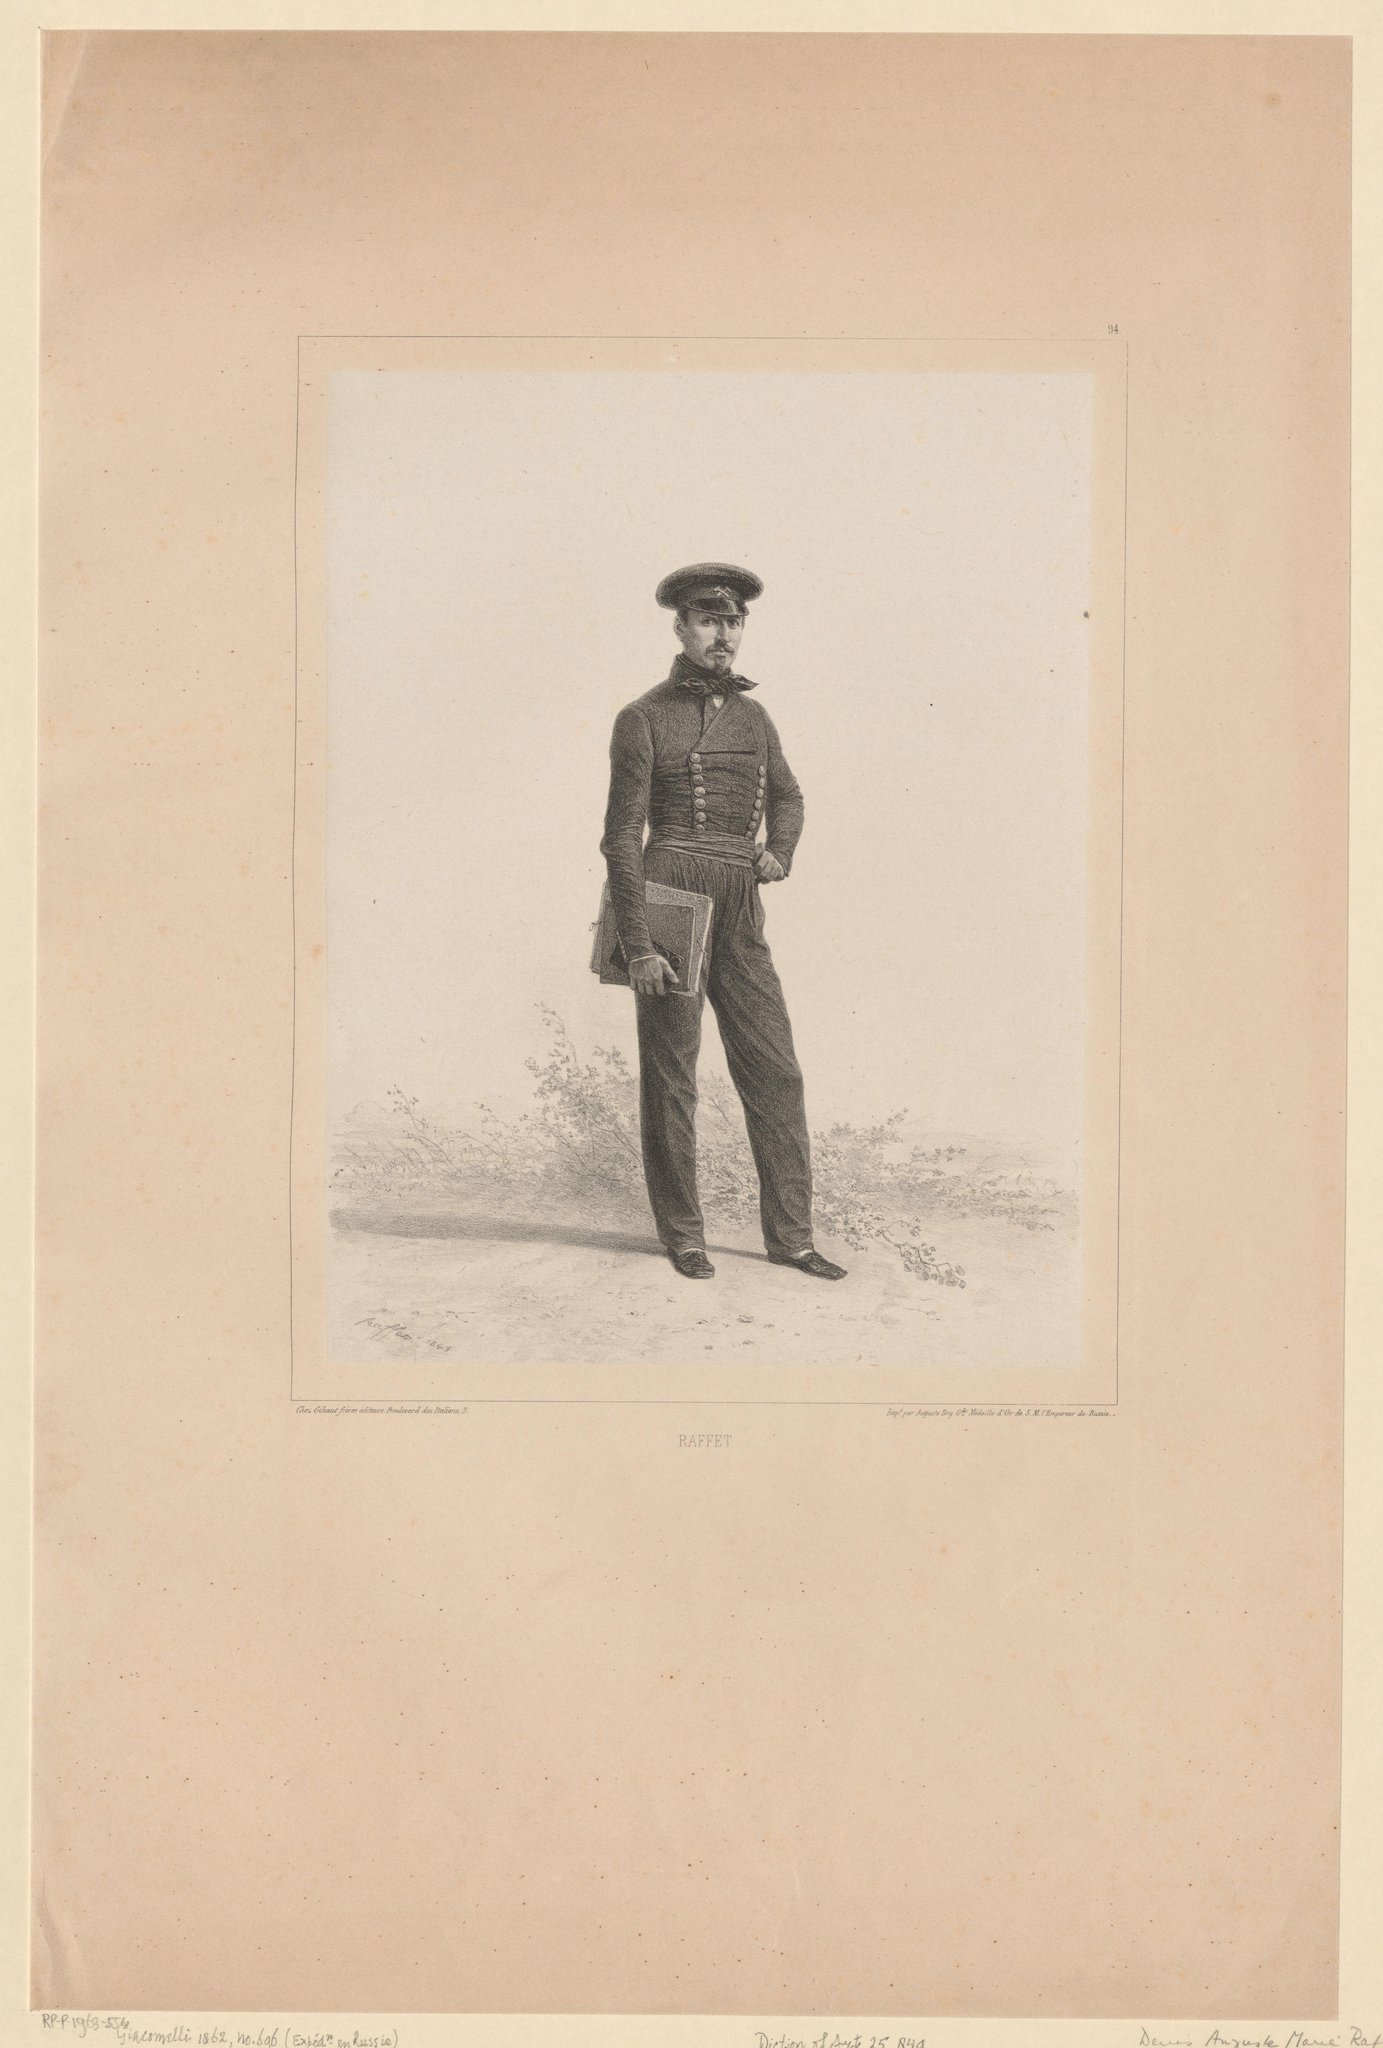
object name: print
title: Zelfportret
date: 1848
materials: paper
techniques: lithograph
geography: paris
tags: denis auguste marie raffet, historical persons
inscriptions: collector's mark: Lugt 2228